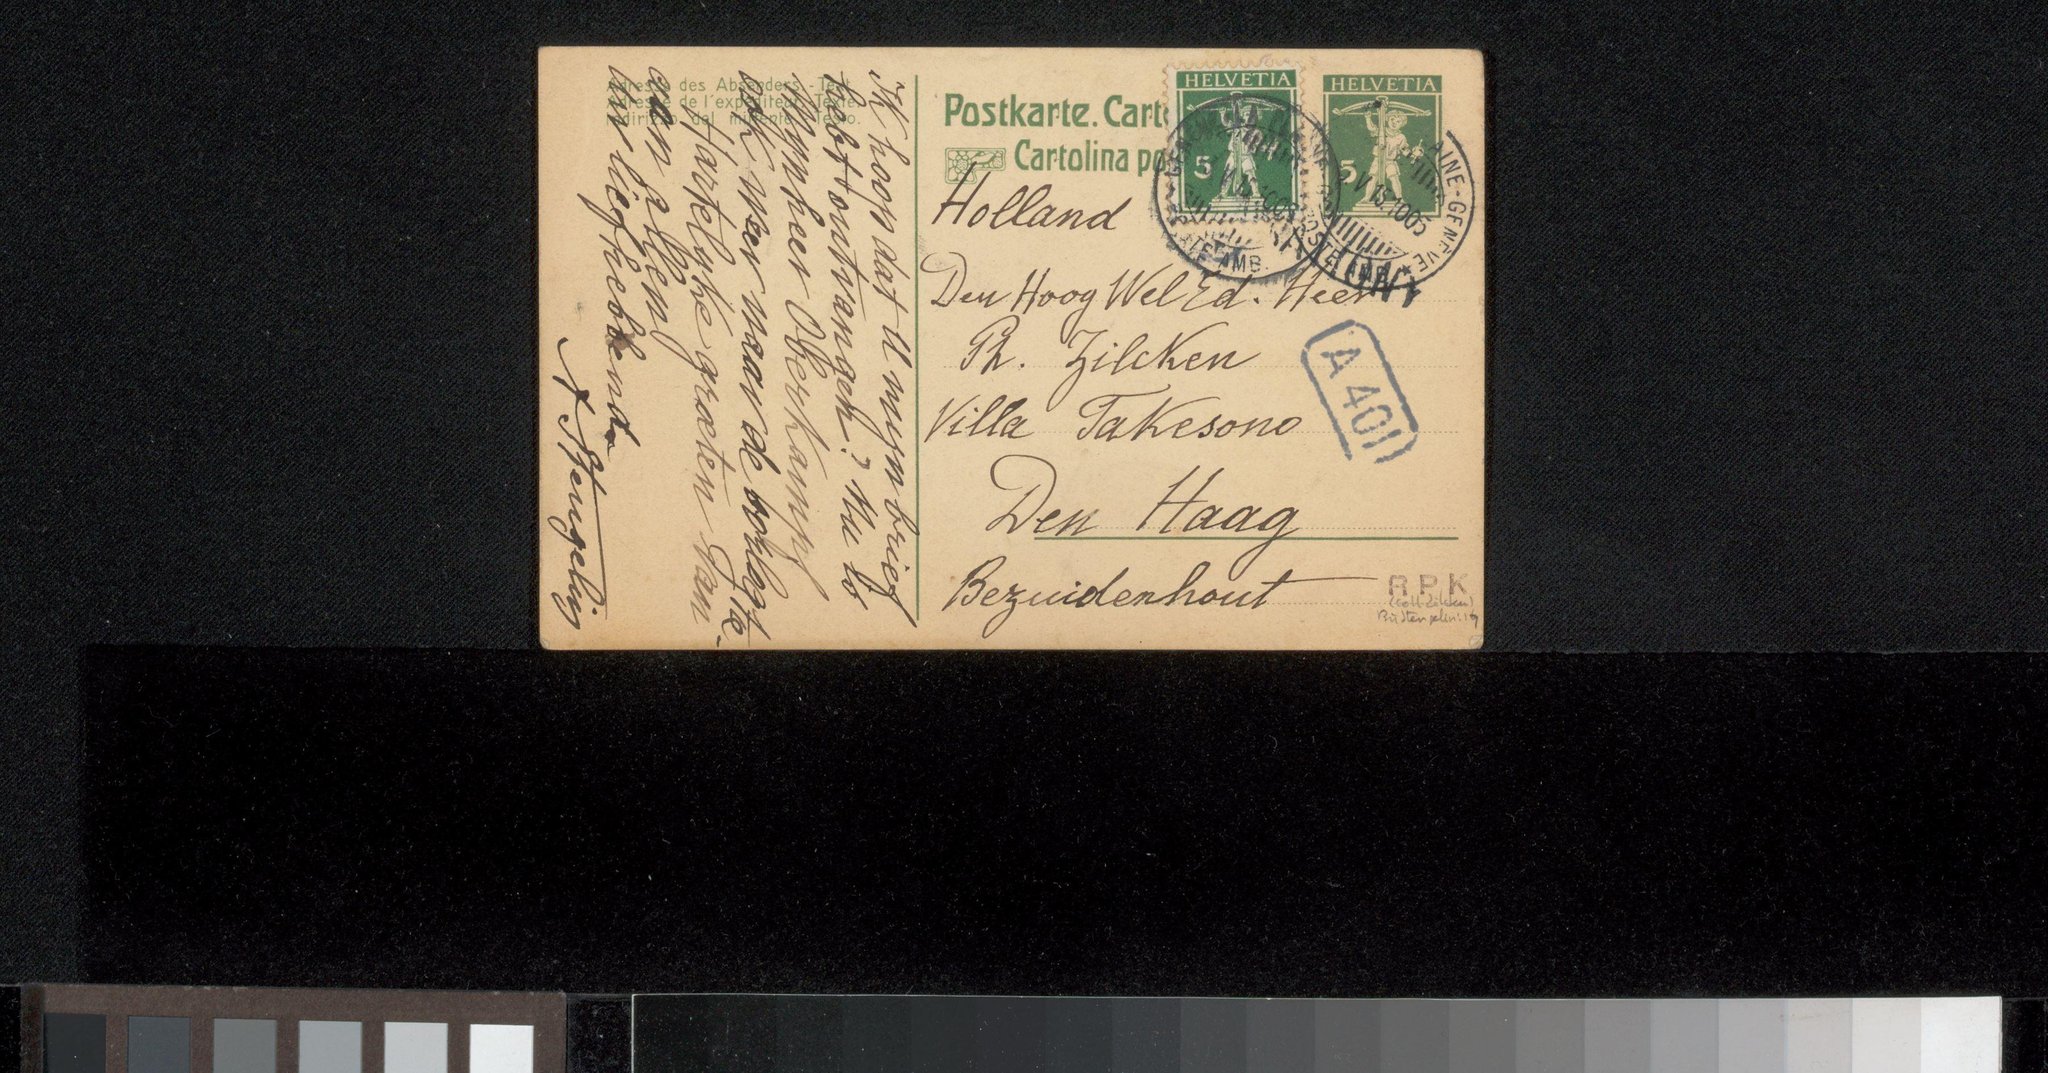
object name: postcard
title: Briefkaart aan Philip Zilcken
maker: alphonse stengelin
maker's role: painter, print maker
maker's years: 1852-1938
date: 1915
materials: cardboard, ink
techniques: pen, writing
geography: satigny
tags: roger louis de oberkampf dabrun, draughtsman, philip zilcken, the graphic arts, diseases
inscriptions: collector's mark: ‘RPK’